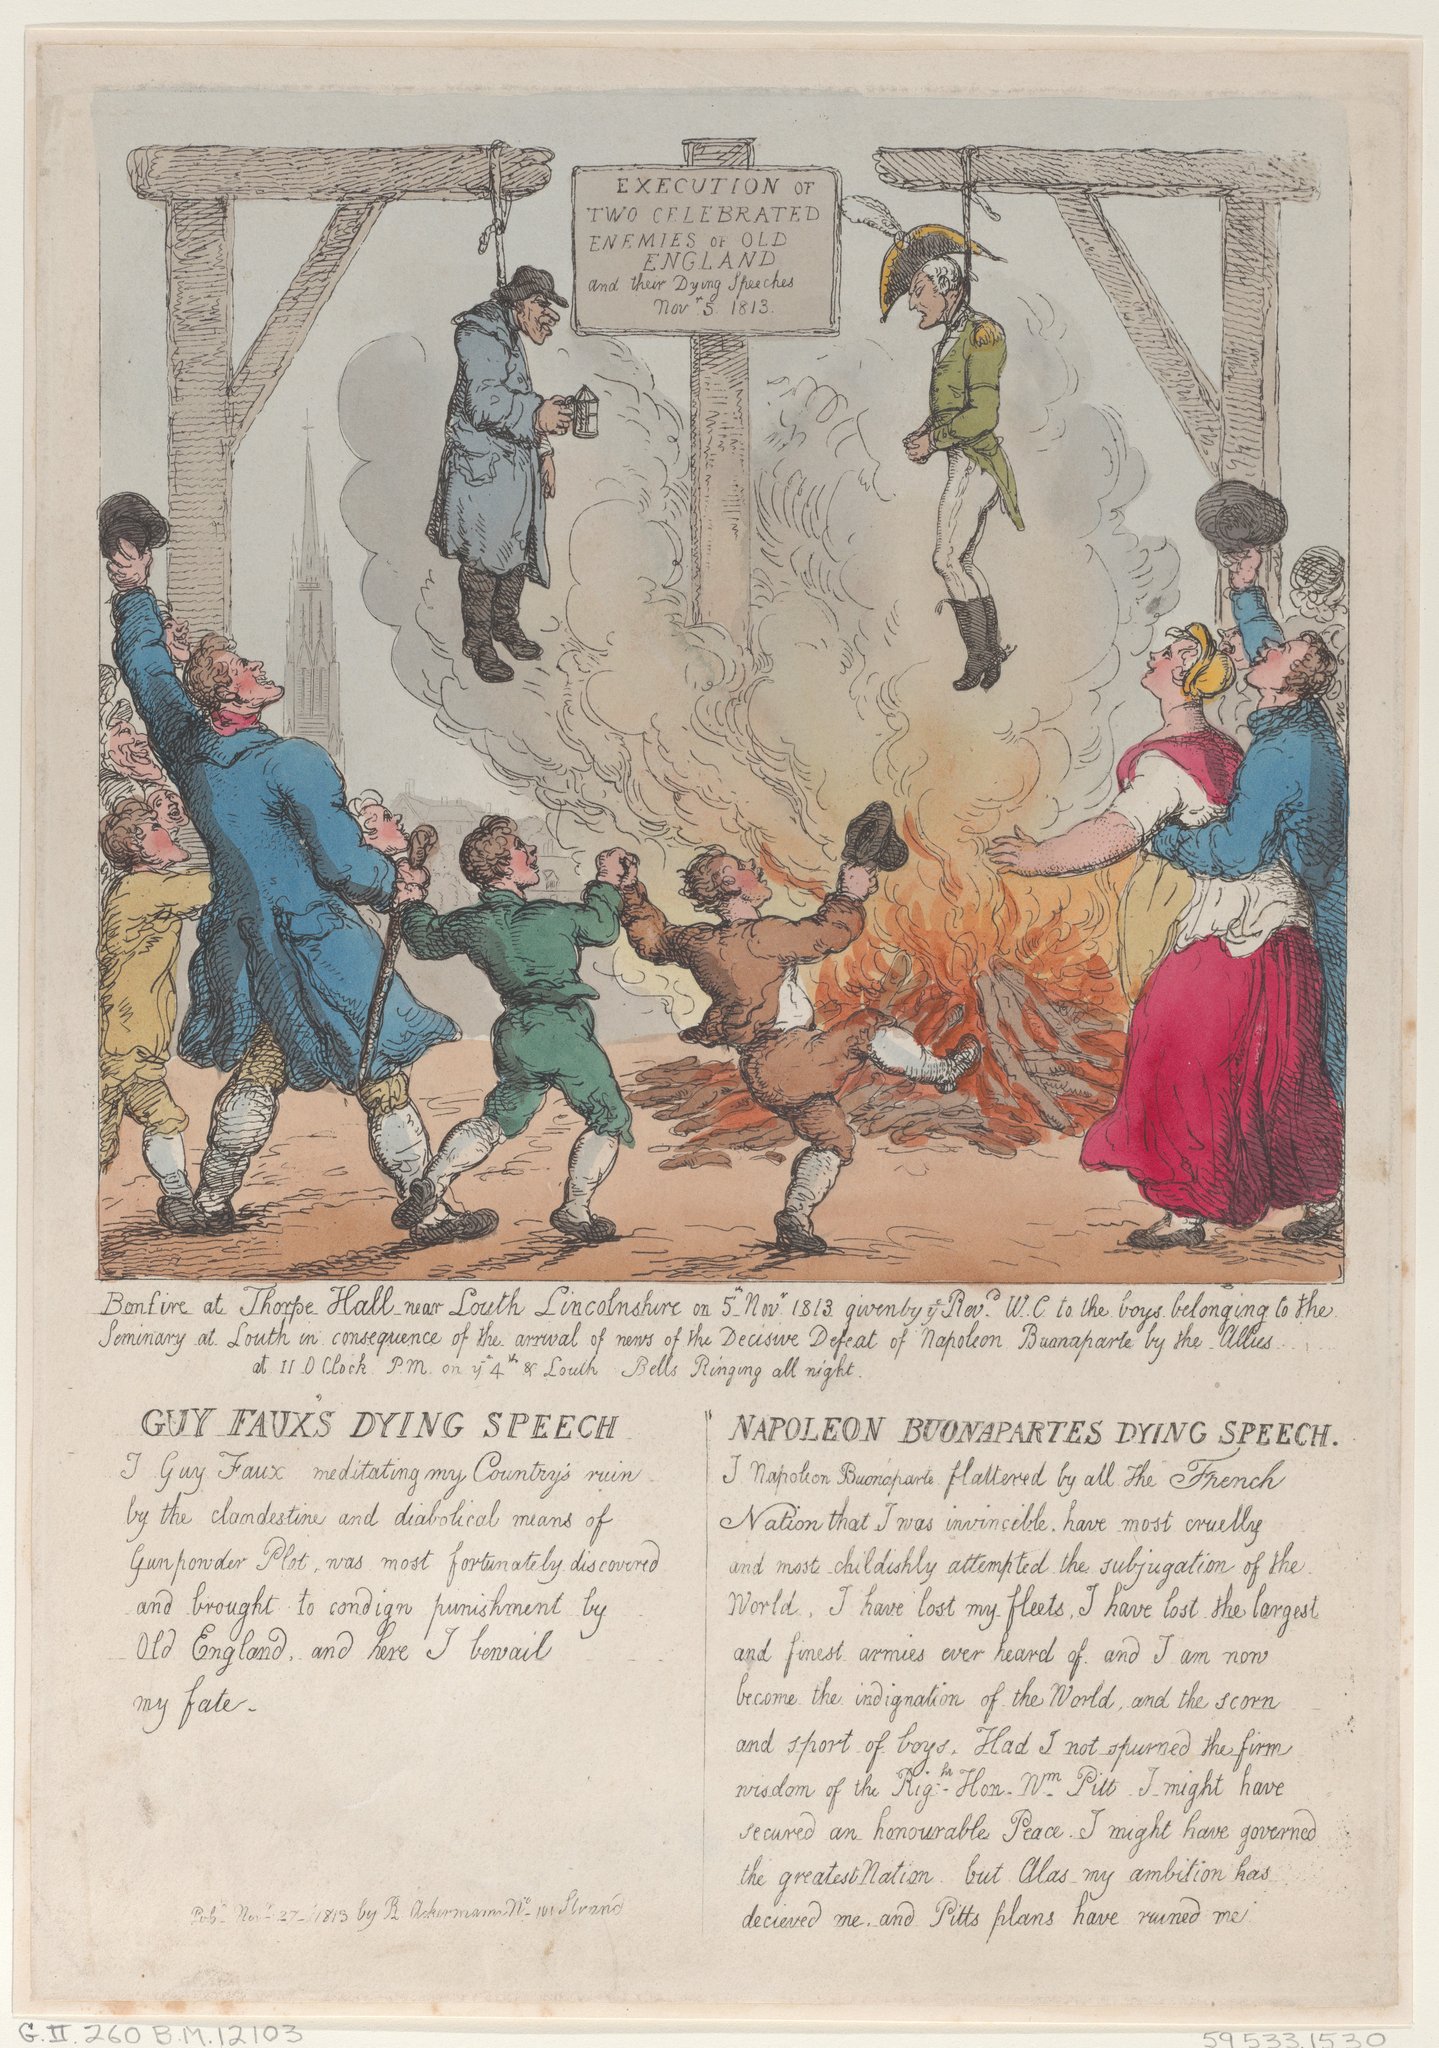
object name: print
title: Execution of Two Celebrated Enemies of Old England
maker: thomas rowlandson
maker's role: artist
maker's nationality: british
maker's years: 1757-1827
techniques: etching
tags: satire,napoleon i,execution,politics